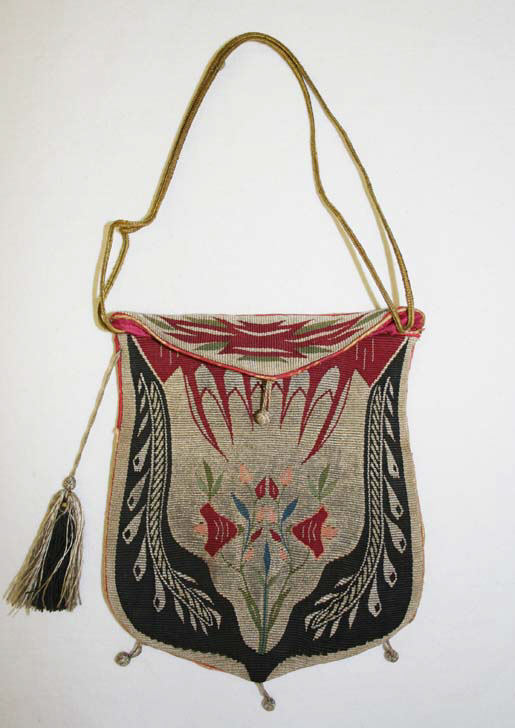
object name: purse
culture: french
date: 1767-1800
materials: silk